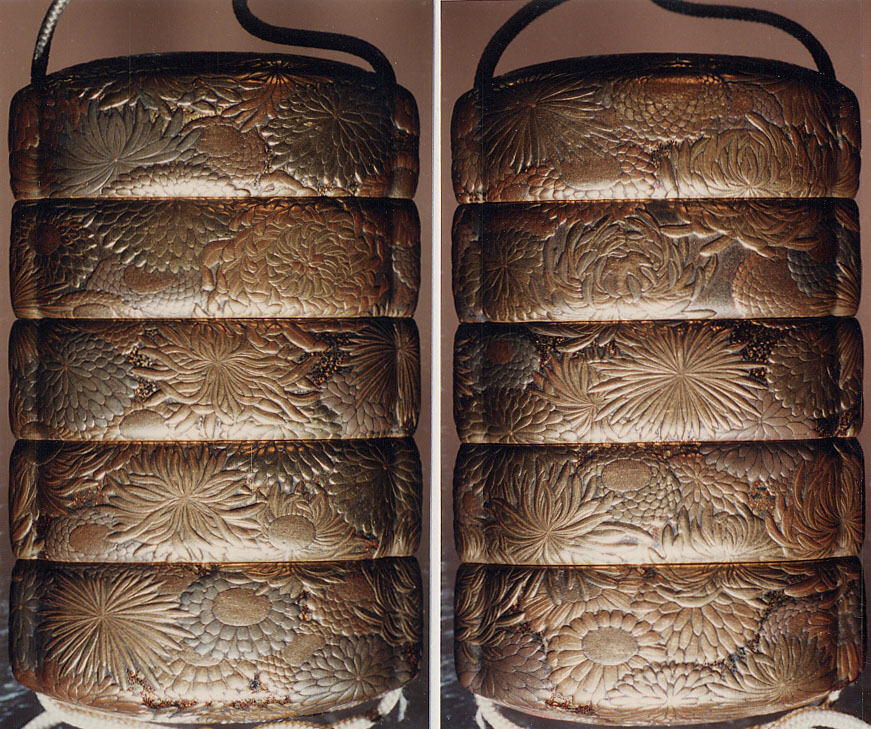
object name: inrō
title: Case (Inrō) with Design of Chrysanthemum Blossoms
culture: japanese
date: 1801-1900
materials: gold, lacquer, silver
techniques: fundame, hiramakie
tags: flowers